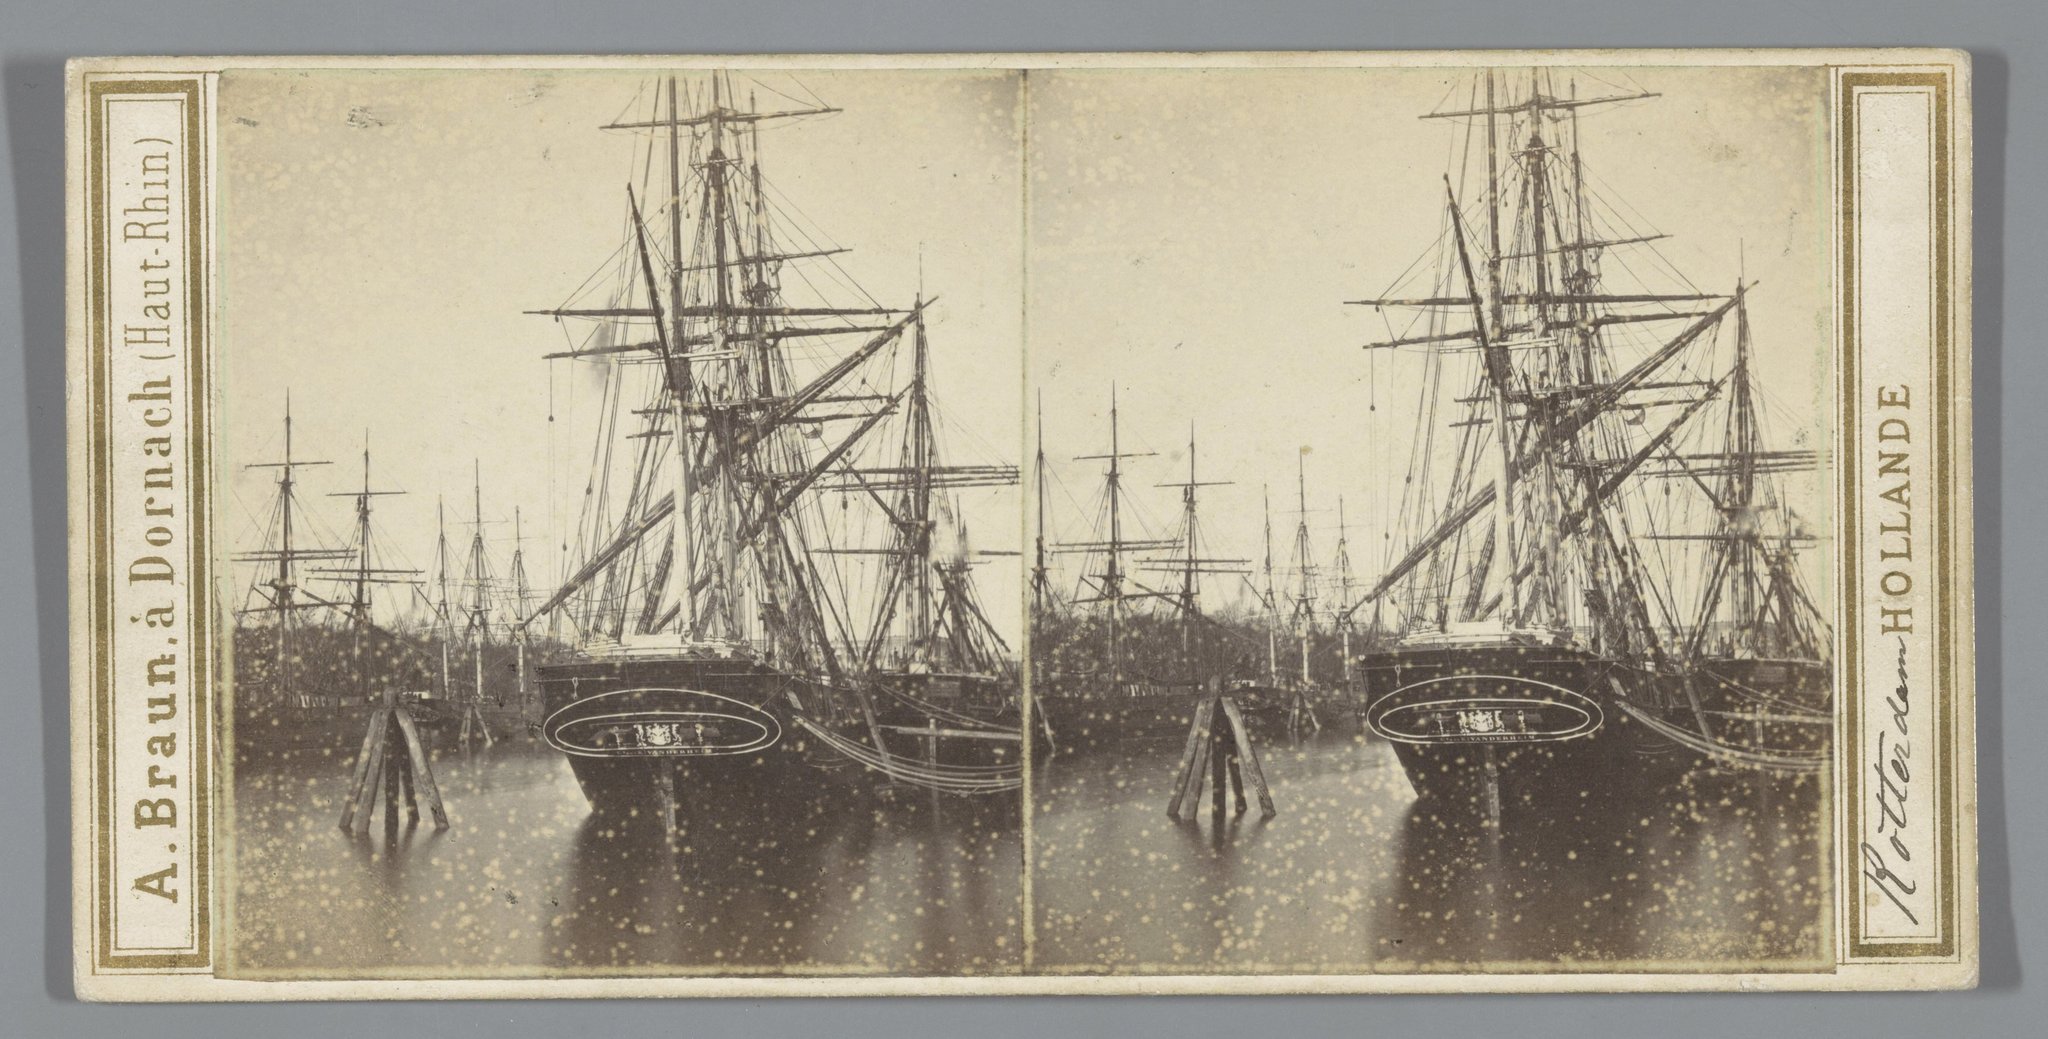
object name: stereograph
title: Rotterdam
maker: gaston braun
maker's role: fotograaf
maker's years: 1845-1928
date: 1864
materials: cardboard, paper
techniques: albumen print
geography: veerhaven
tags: harbour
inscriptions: number: ‘No 3815.’